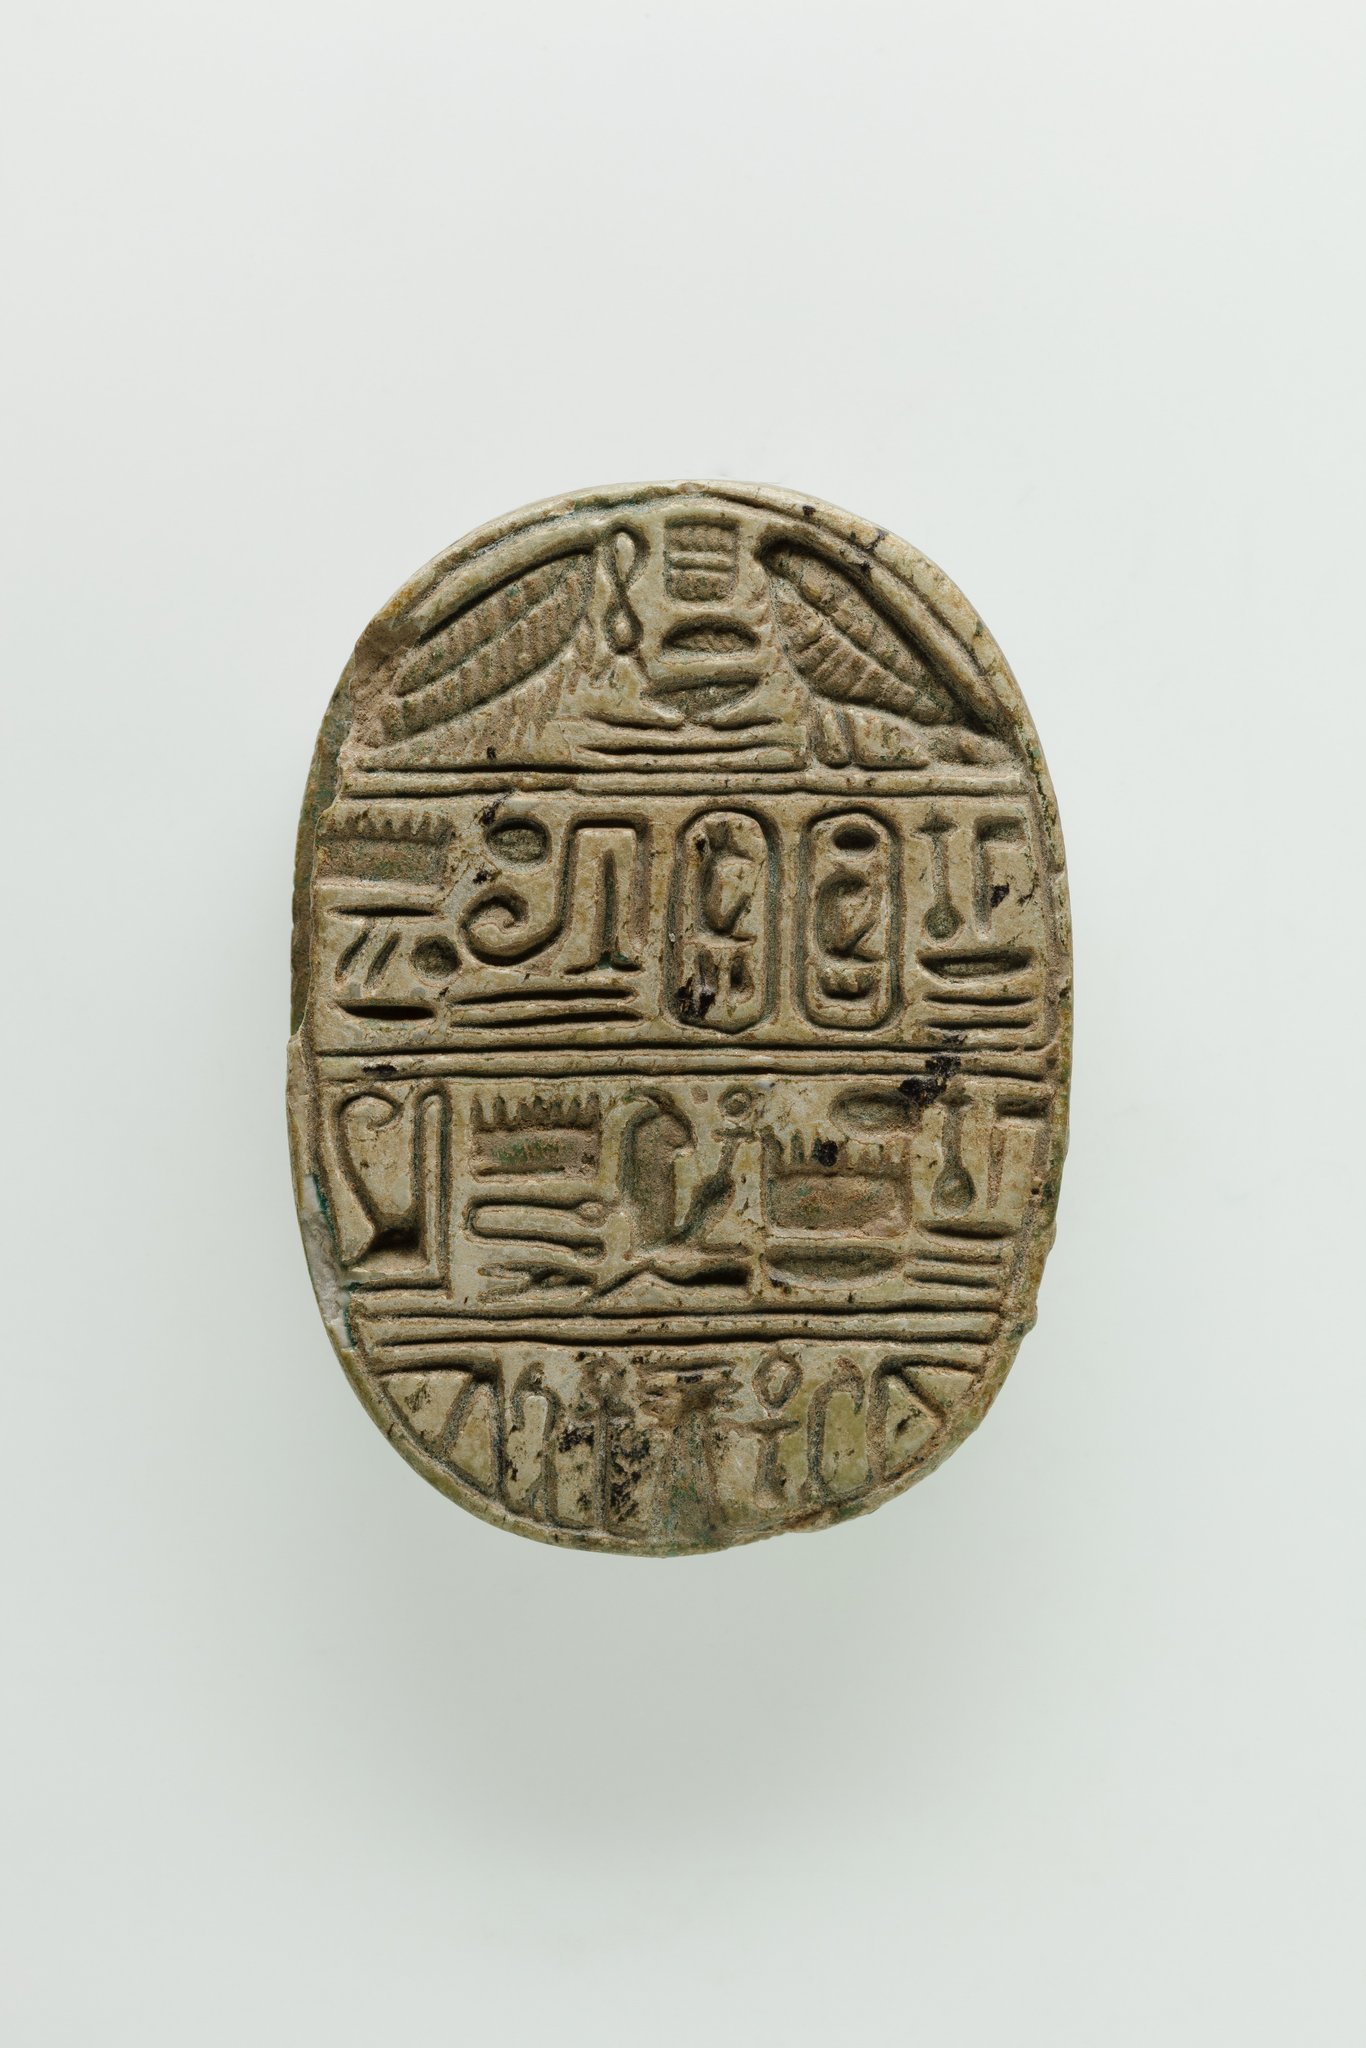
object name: scarab, seti i, hieroglyph, royal title, epithet, ptah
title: Fragment of Scarab Inscribed for Seti I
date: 1294-1279 BCE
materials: stone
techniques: glazing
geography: egypt